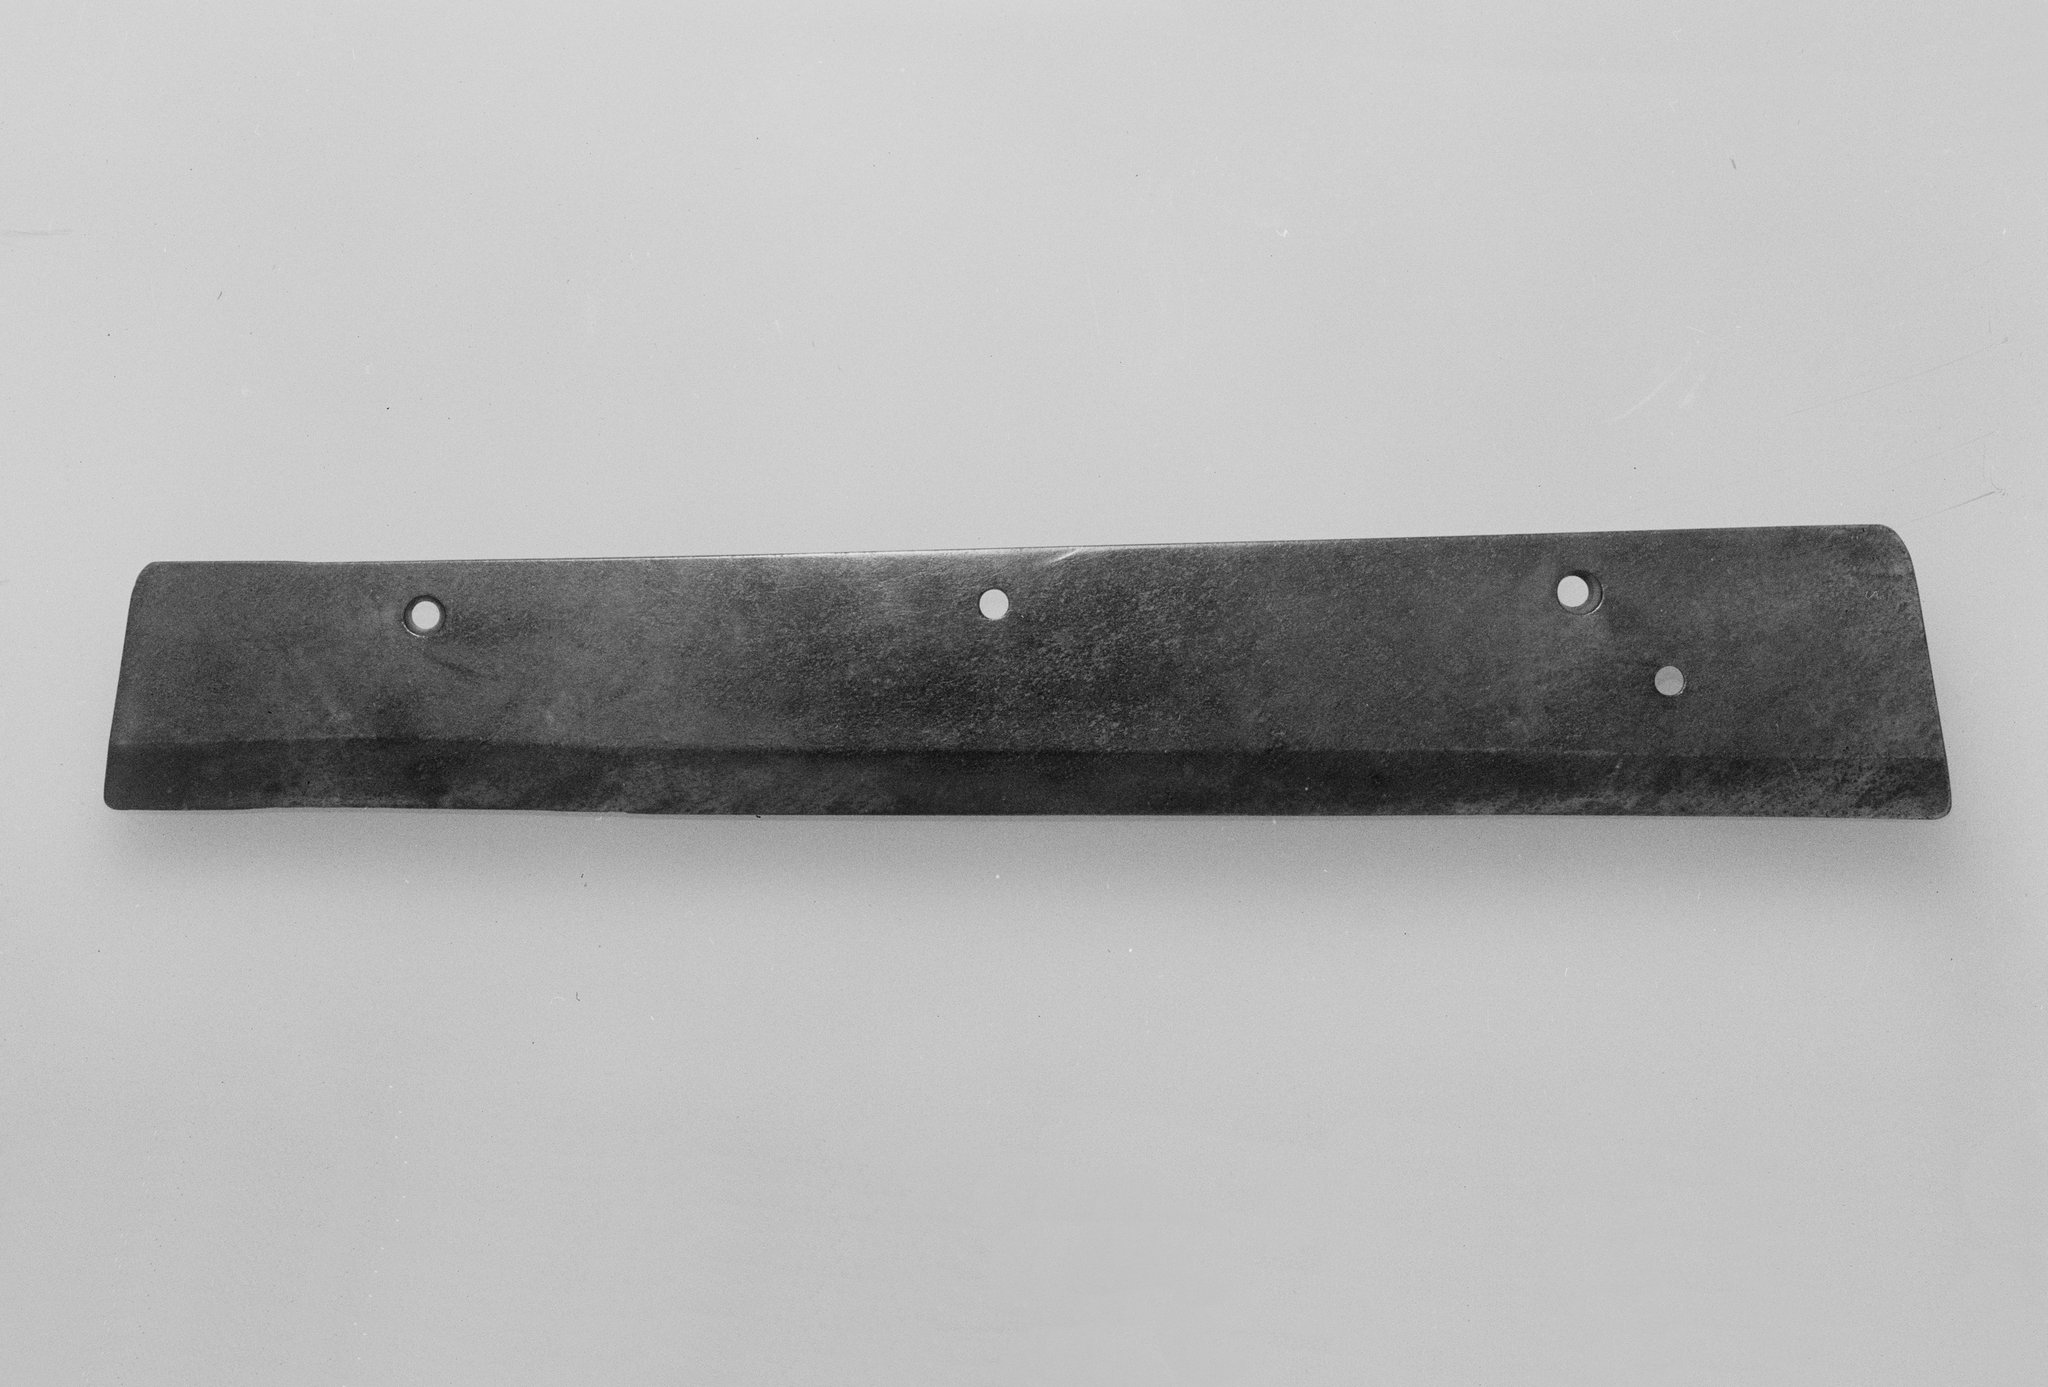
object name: knife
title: Ceremonial blade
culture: chinese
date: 2000-1001 BCE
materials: jade